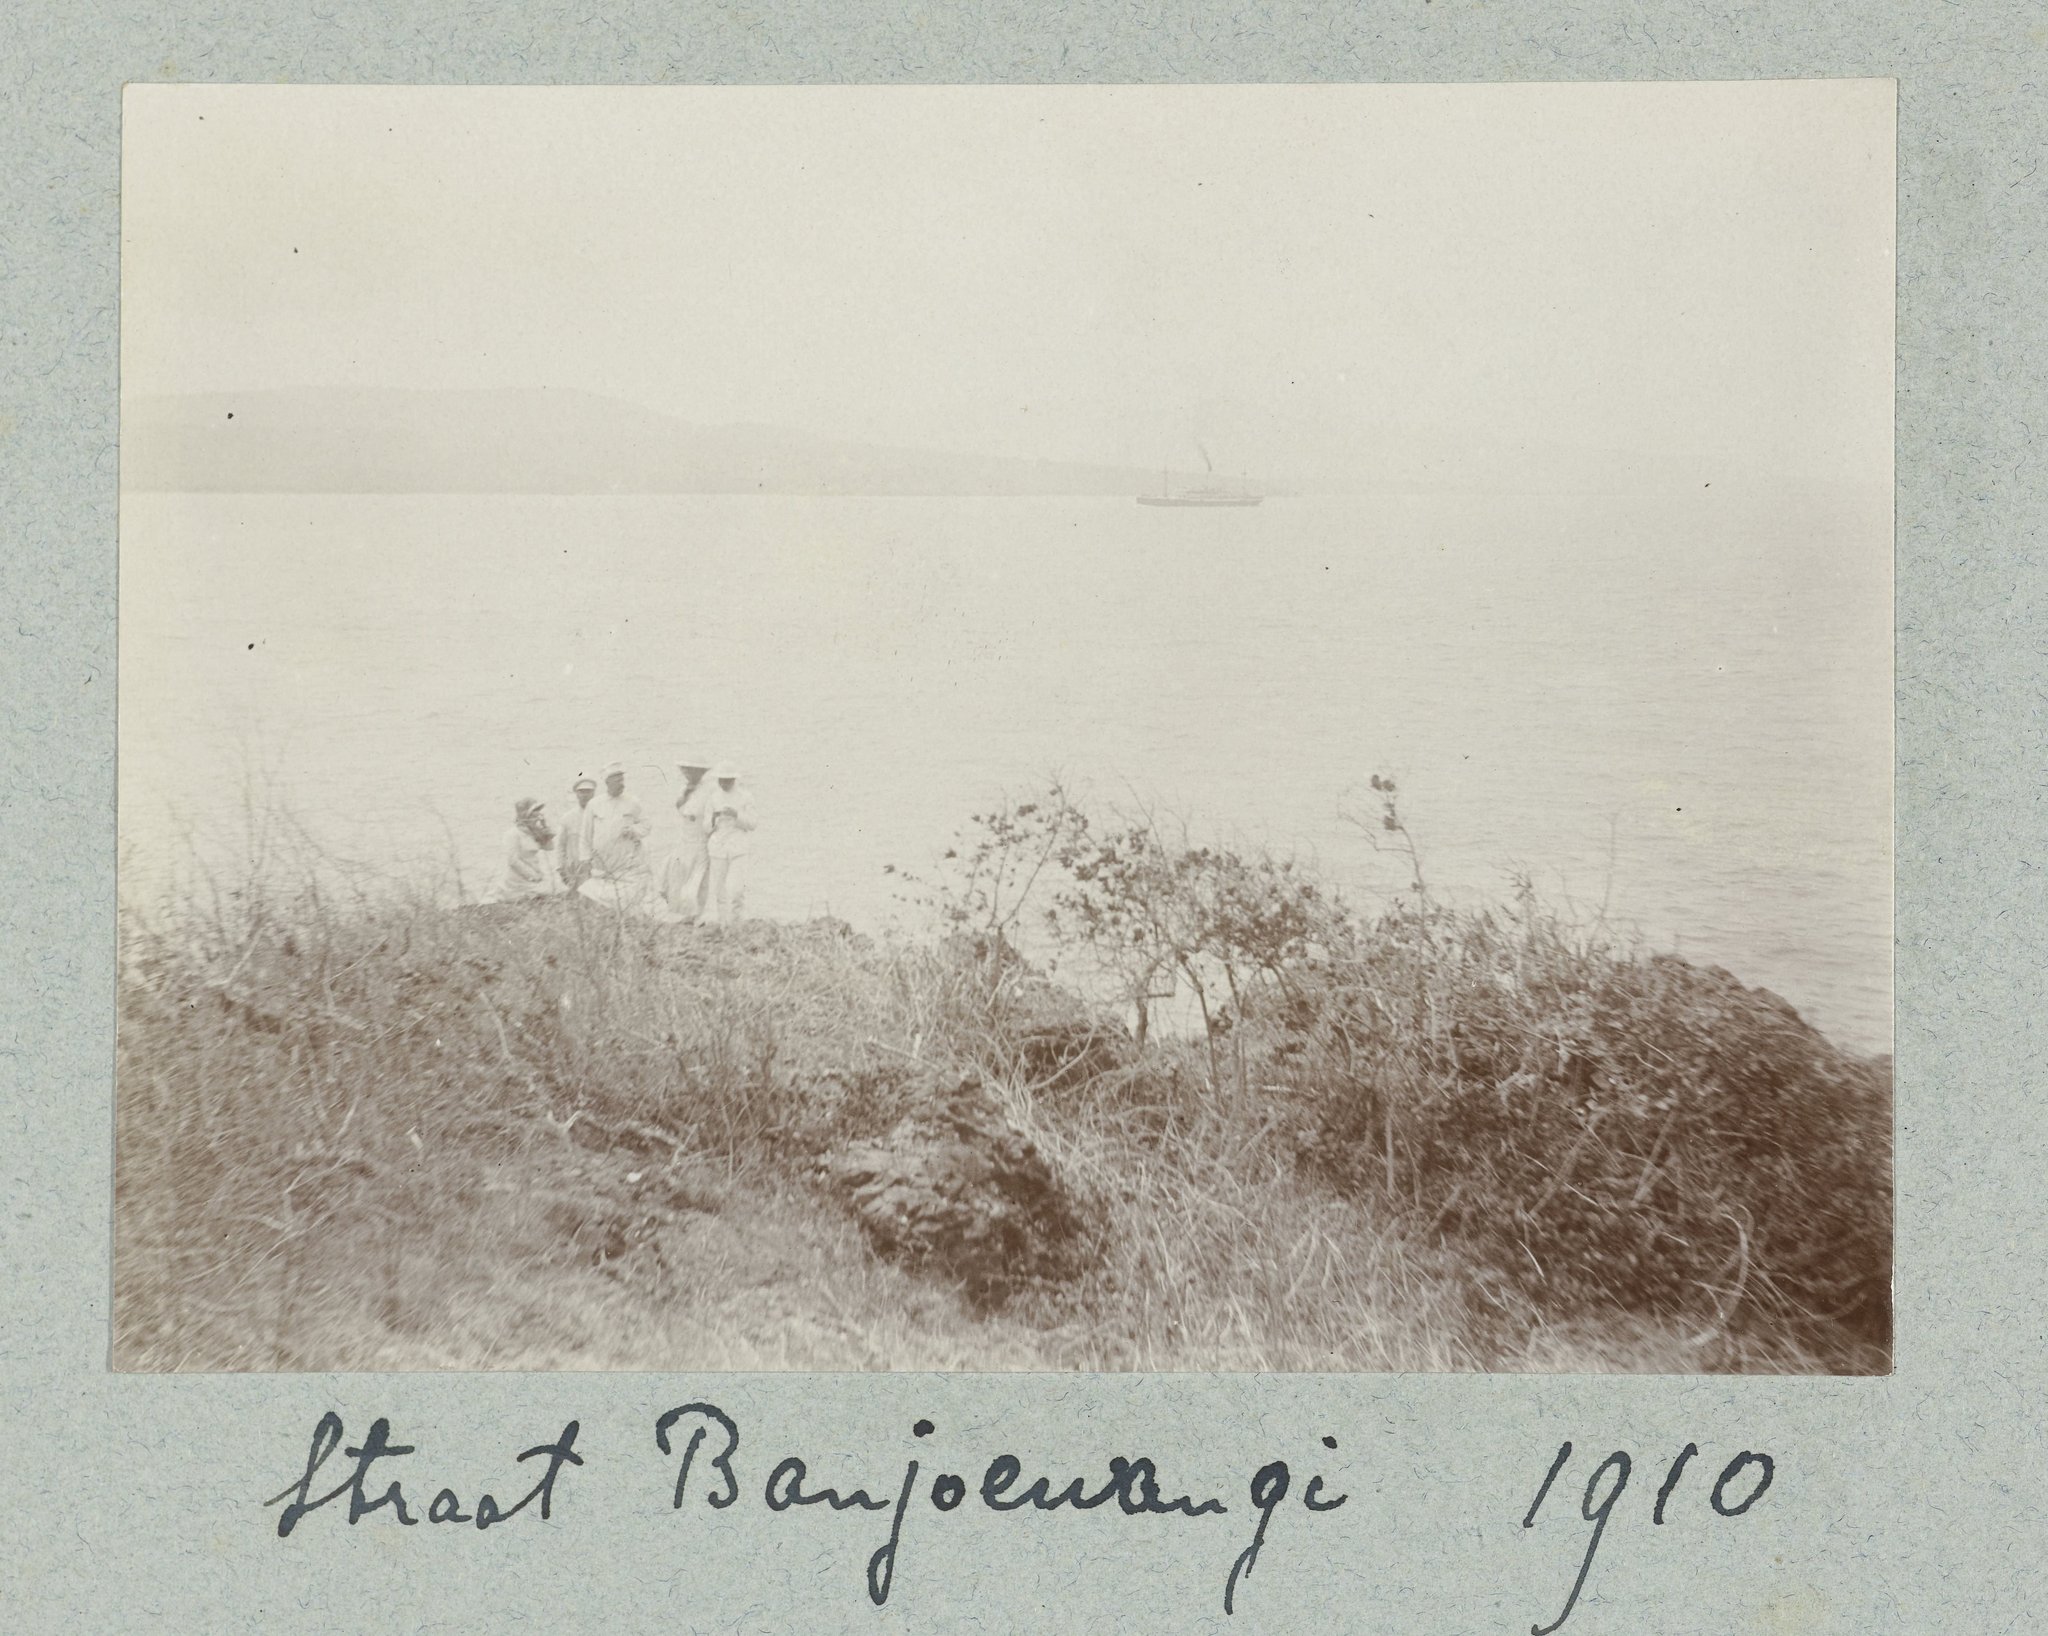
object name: photograph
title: Straat Banjoewangi 1910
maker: frits freerks fontein fz.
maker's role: fotograaf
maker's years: 1882-1928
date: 1910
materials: cardboard, paper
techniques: gelatin silver print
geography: netherlands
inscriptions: caption: ‘Straat Banjoewangi 1910’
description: De mannen dragen witte tropenuniformen waarvan een man met tropenhelm, twee andere mannen dragen een strooien hoed, de vrouwen dragen witte jurken of batik rokken met witte hes. Foto uit album 'Photographieën".